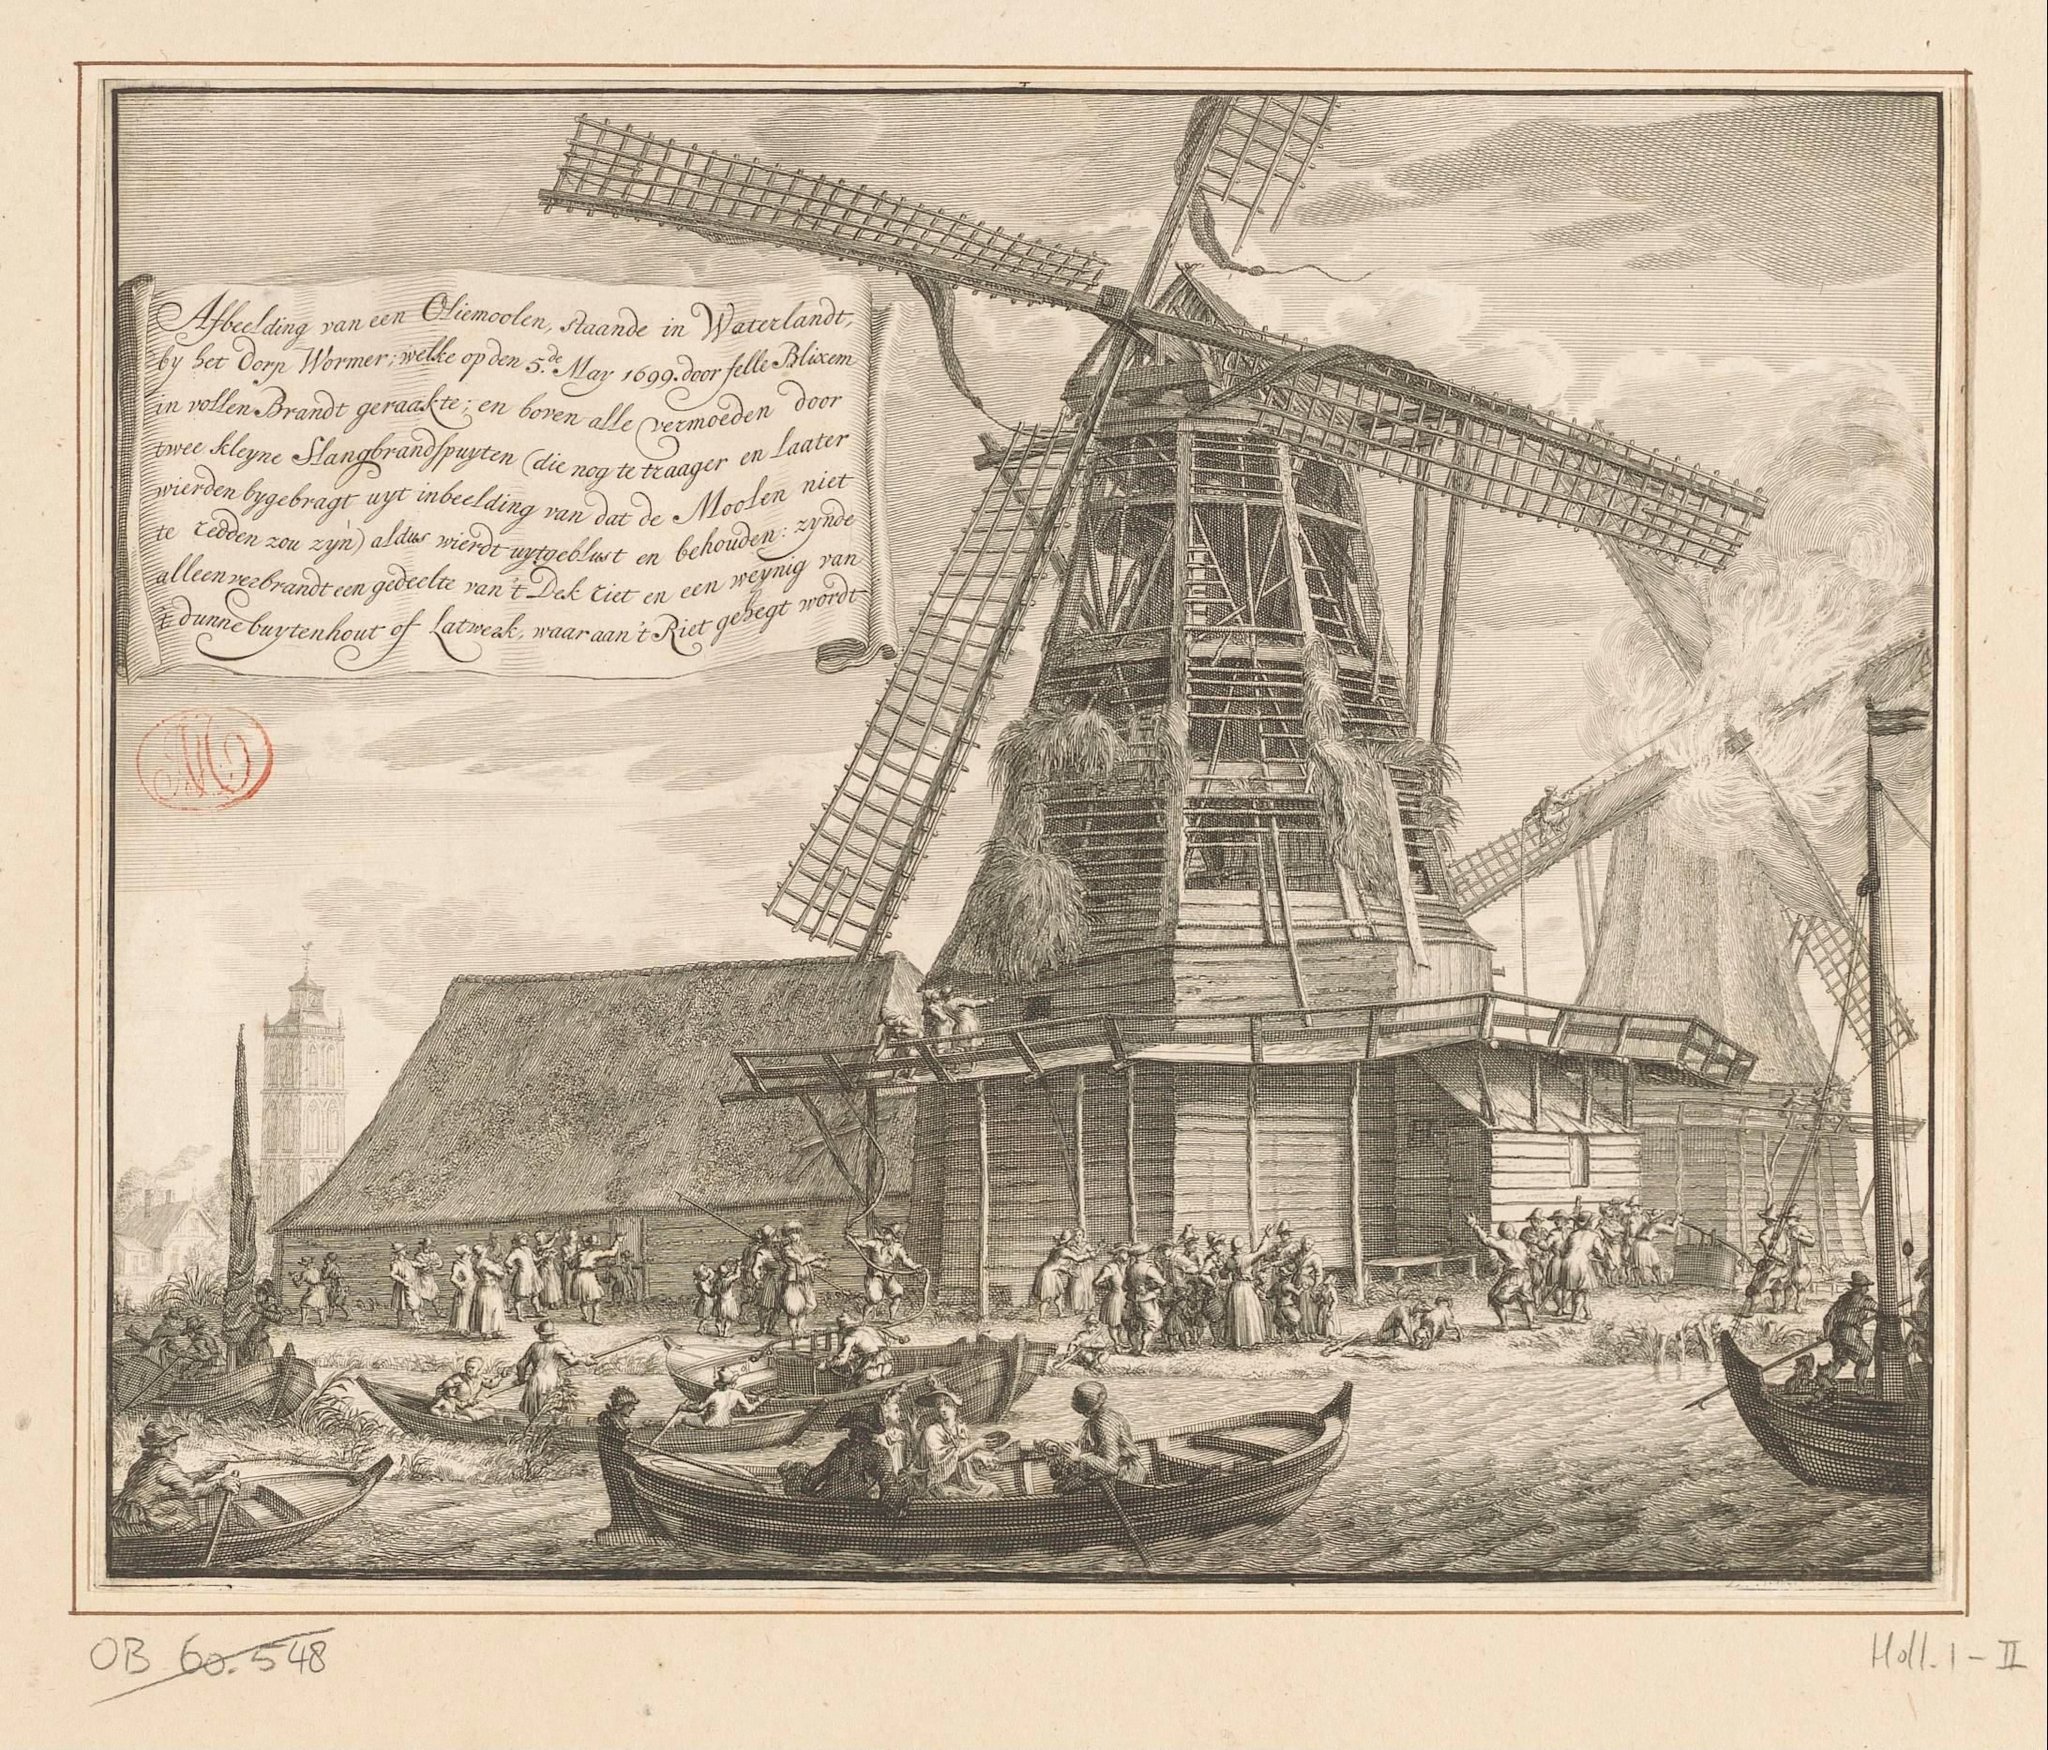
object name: print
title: Brand in oliemolen De Zeug bij Wormer, 1699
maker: laurens scherm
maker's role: draughtsman, print maker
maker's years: 1671-1702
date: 1699-1702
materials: paper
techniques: engraving, etching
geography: amsterdam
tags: amsterdam, painter, print maker, draughtsman, jan van der heyden, pump (fire-extinguishing equipment), windmill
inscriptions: collector's mark: Lugt 195, collector's mark: Lugt 2228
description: Zicht op oliemolens De Keizer (voorgrond) en De Zeug (achtergrond) bij Wormer. Oliemolen De Zeug werd op 5 mei 1699 getroffen door de bliksem en vatte vlam. Van oliemolen De Keizer is uit voorzorg het rietdek verwijderd om brand door overwaaiende vonken te voorkomen. Door het blussen met een slangbrandspuit is De Zeug grotendeels bewaard gebleven. Linksboven een banderol met een opschrift. Plaat 21 in de herdruk van het Brandspuitenboek van Jan van der Heyden uit 1735.